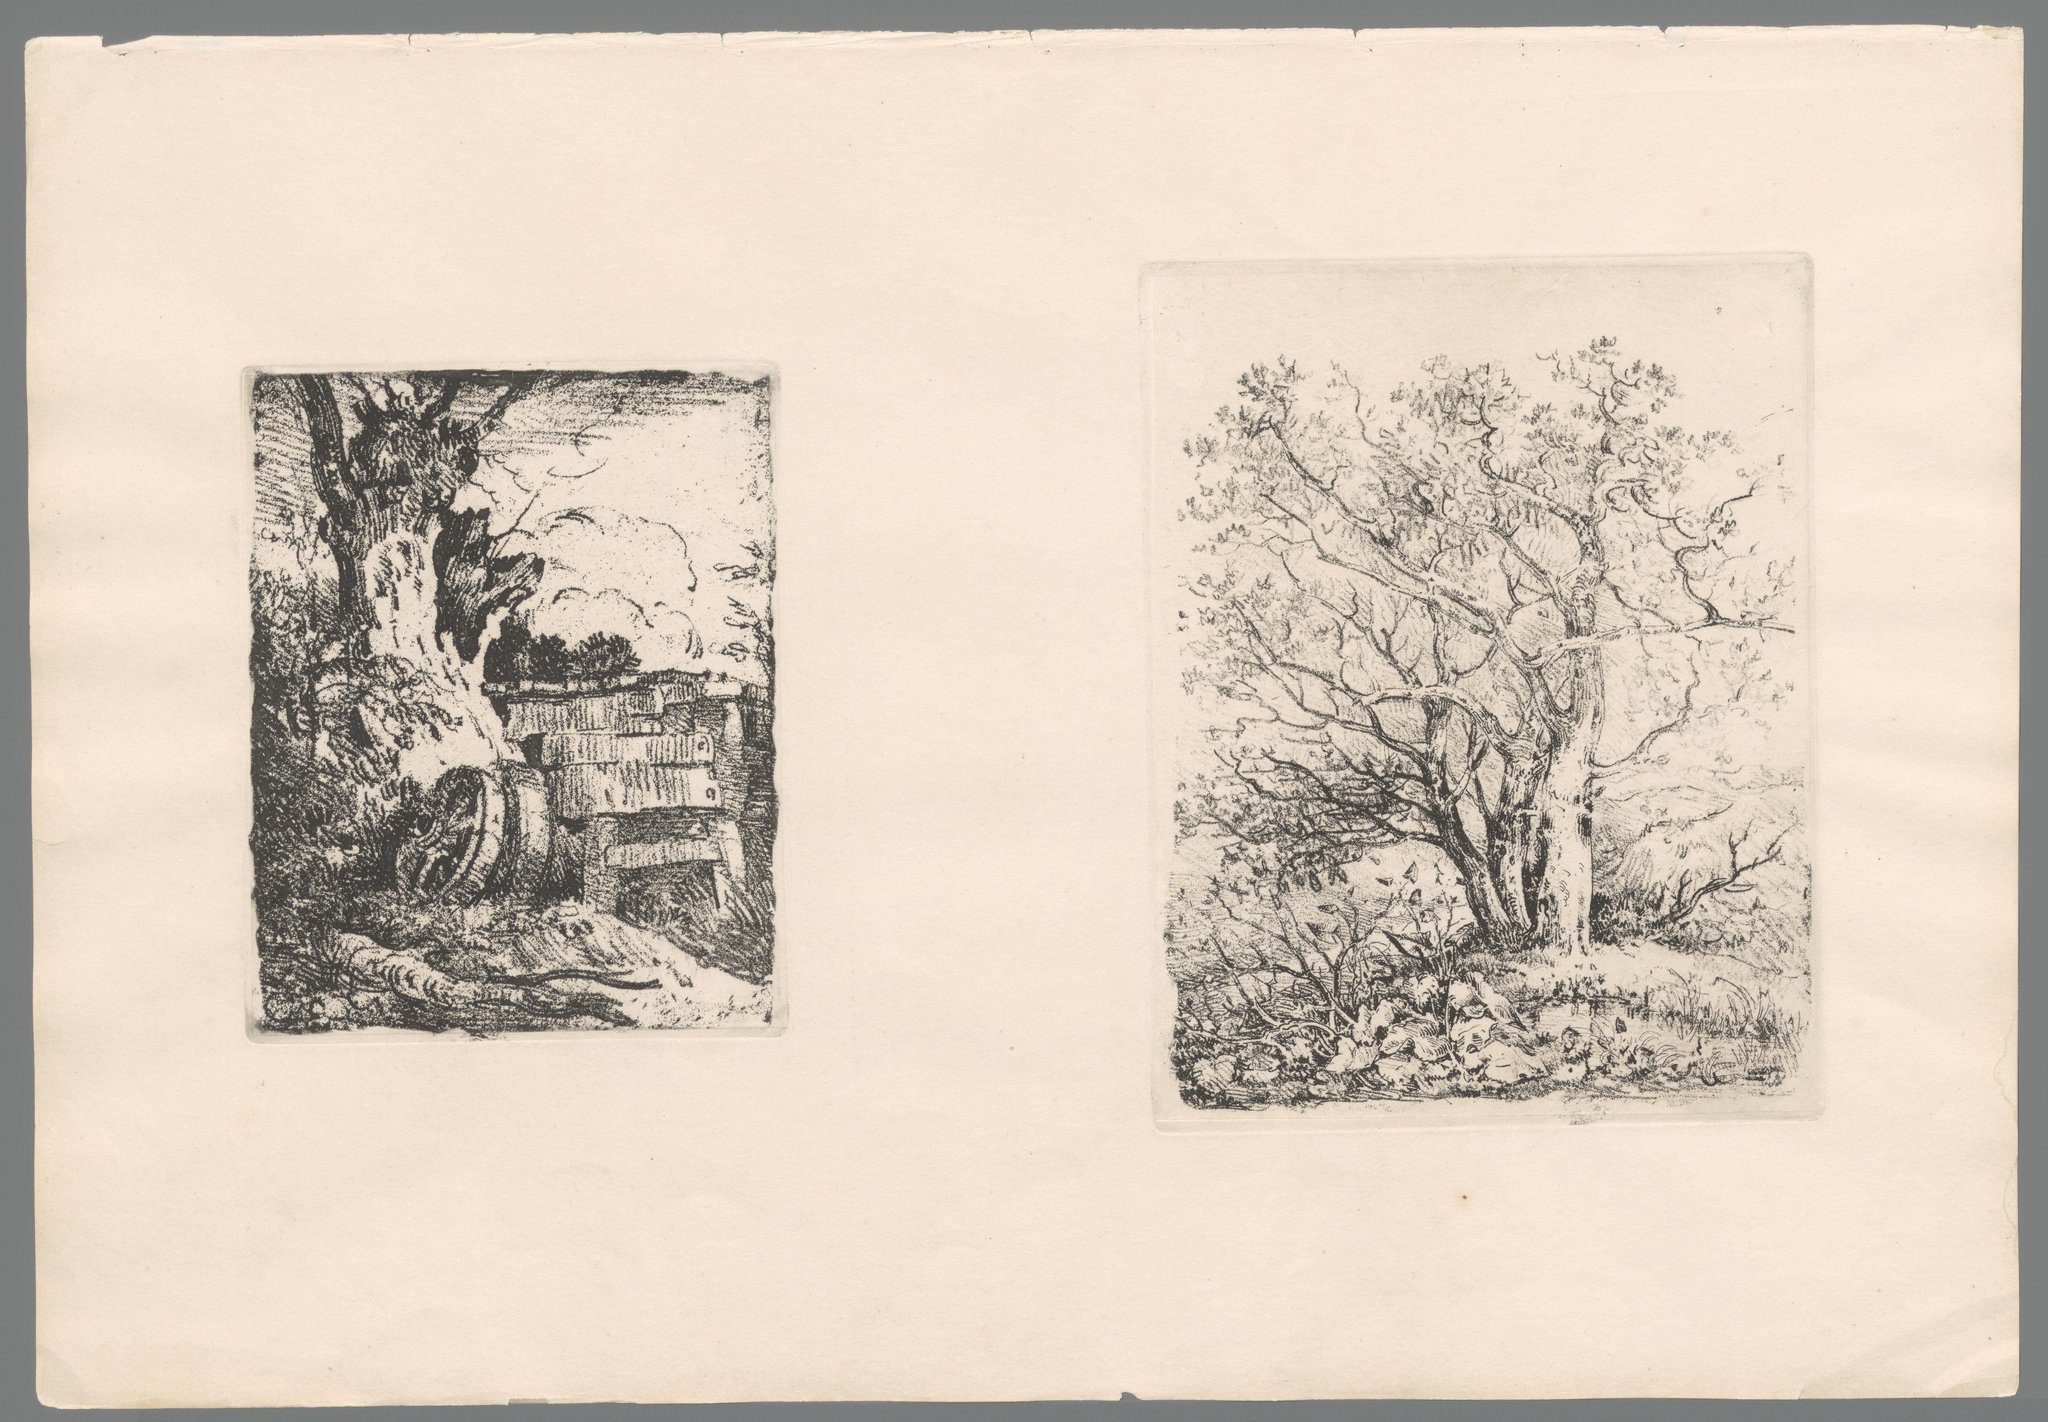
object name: print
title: Waggon Wheels, Tree Trunk and Beams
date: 1834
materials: paper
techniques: soft ground etching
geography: norwich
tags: wheel (of vehicle), beam, log of wood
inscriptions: collector's mark: Lugt 2760, collector's mark: Lugt 2228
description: Prent staat samen met RP-P-1973-195 op een onversneden blad.